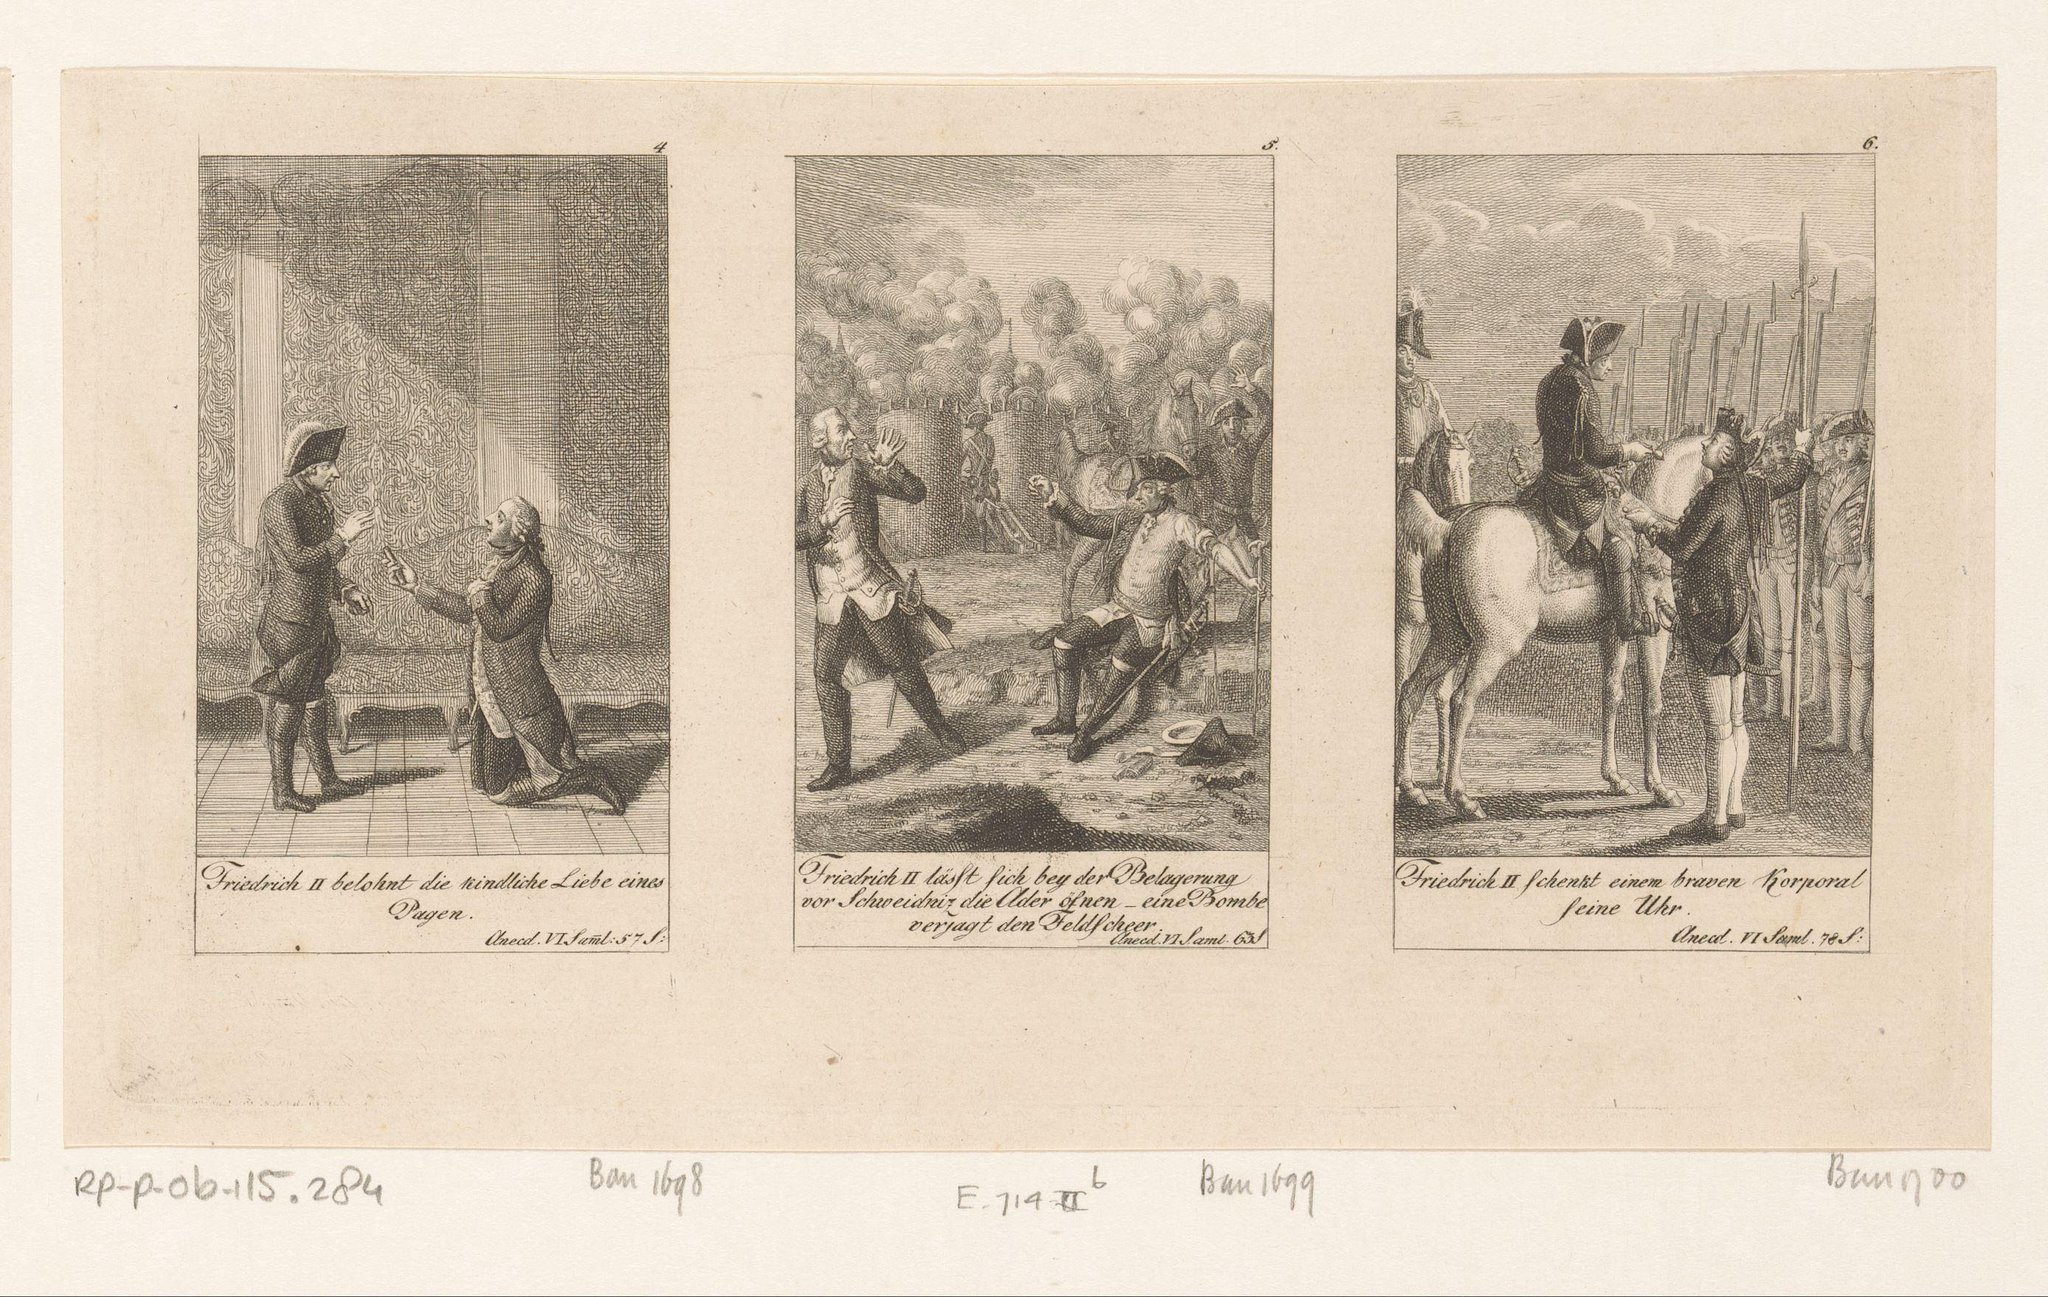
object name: book illustration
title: Drie voorstellingen uit de Anekdoten van Frederik de Grote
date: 1793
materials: paper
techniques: etching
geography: berlin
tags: frederick ii (king of prussia), review, inspection (of company, unit, troop), history, undressing oneself, getting undressed, ruler, sovereign, kneeling figure, siege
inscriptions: collector's mark: Lugt 2228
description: Prenten gebruikt voor: Königl. Grosbritanischer Historischer Genealogischer Calender für 1794 (...). Lauenburg: Johann Georg Berenberg, [1793].